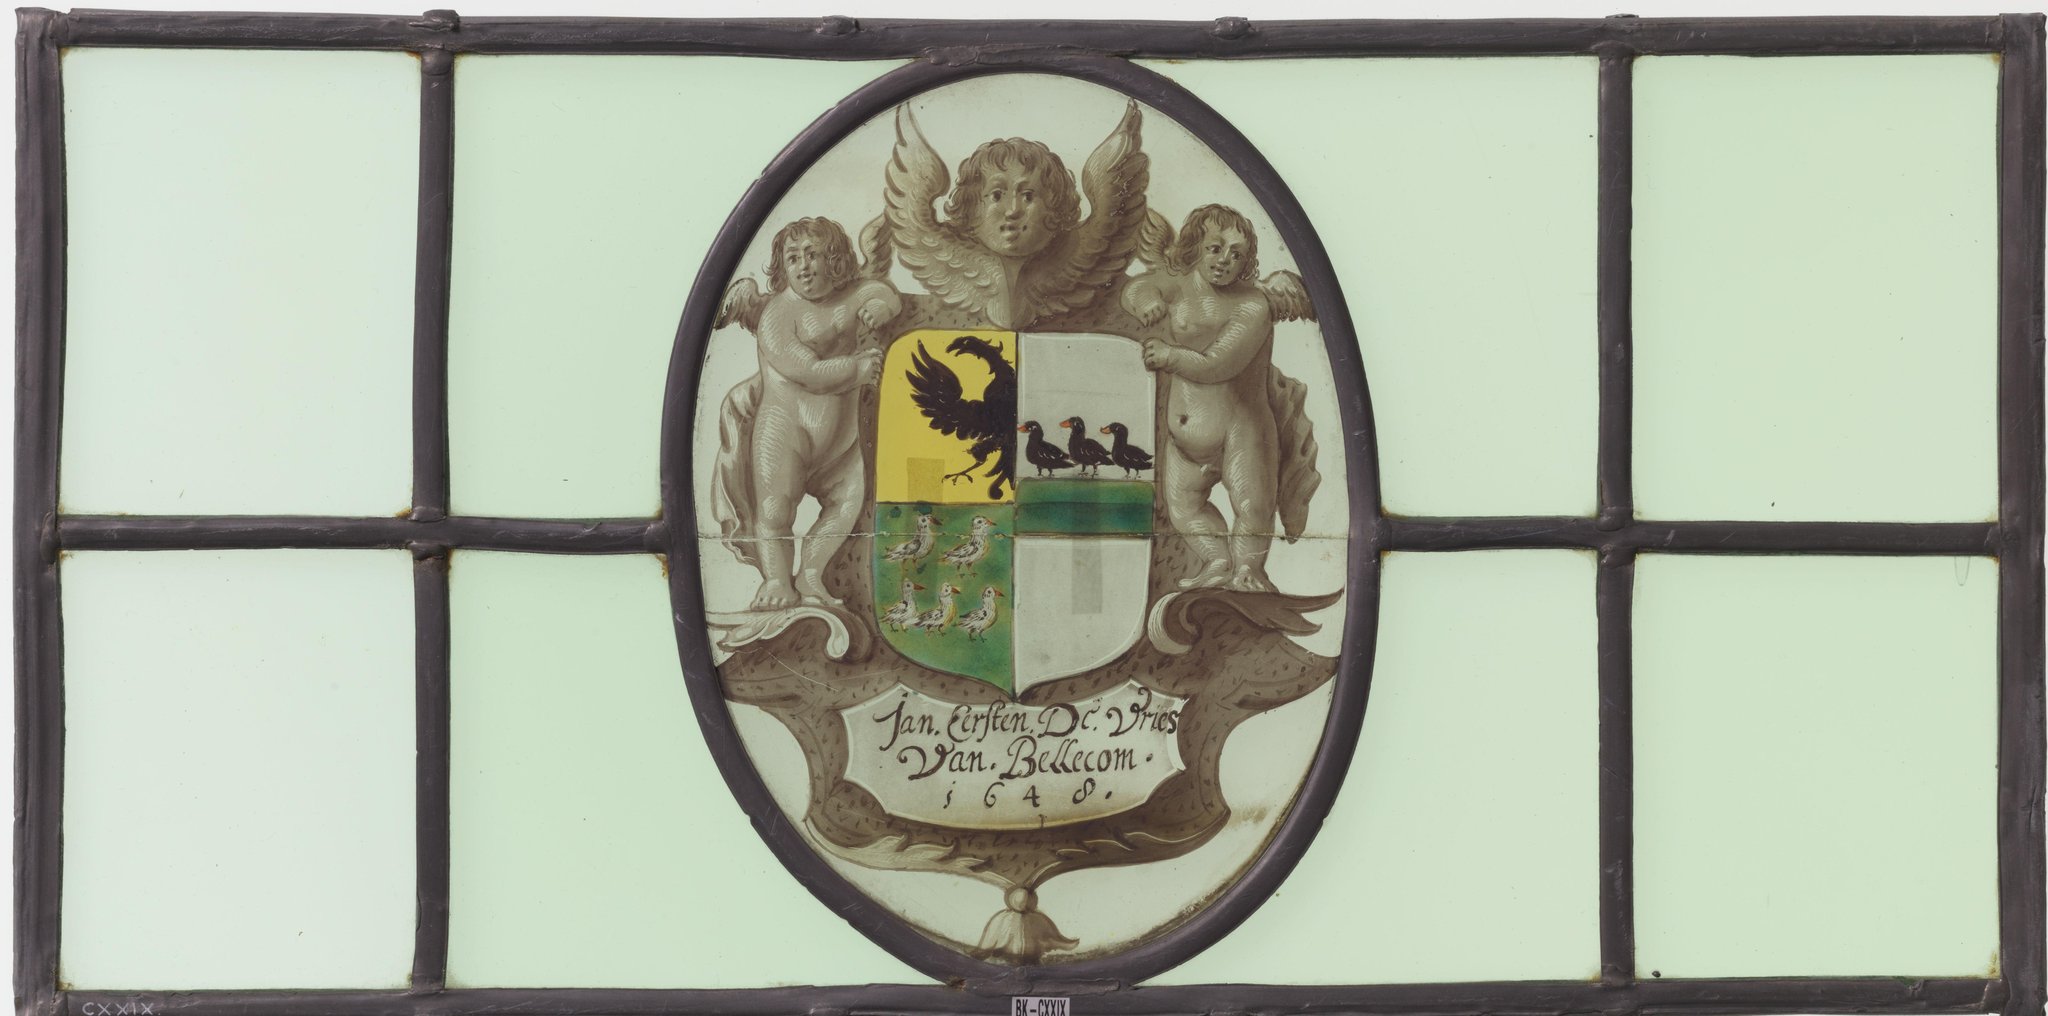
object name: light window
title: Ruit met wapen en onderschrift "Jan Eersten De Vries Van Bellecom 1648"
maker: Anonymous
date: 1648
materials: glass, lead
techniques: leading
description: Ruit met wapen en onderschrift "Jan Eersten De Vries Van Bellecom 1648".